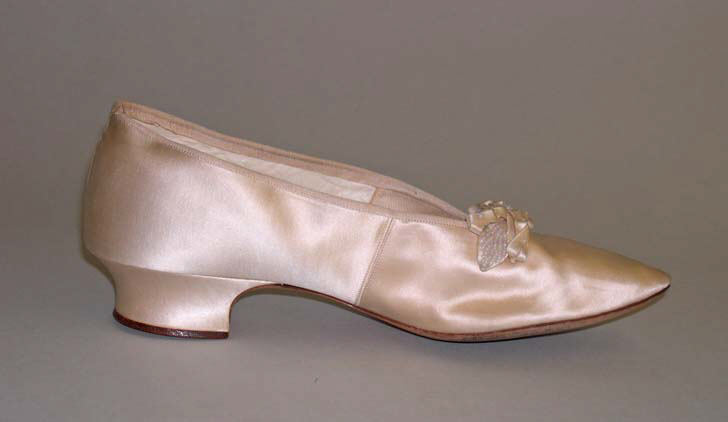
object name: slipper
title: Slippers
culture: american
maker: j. & j. slater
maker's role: designer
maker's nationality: american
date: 1894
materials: leather